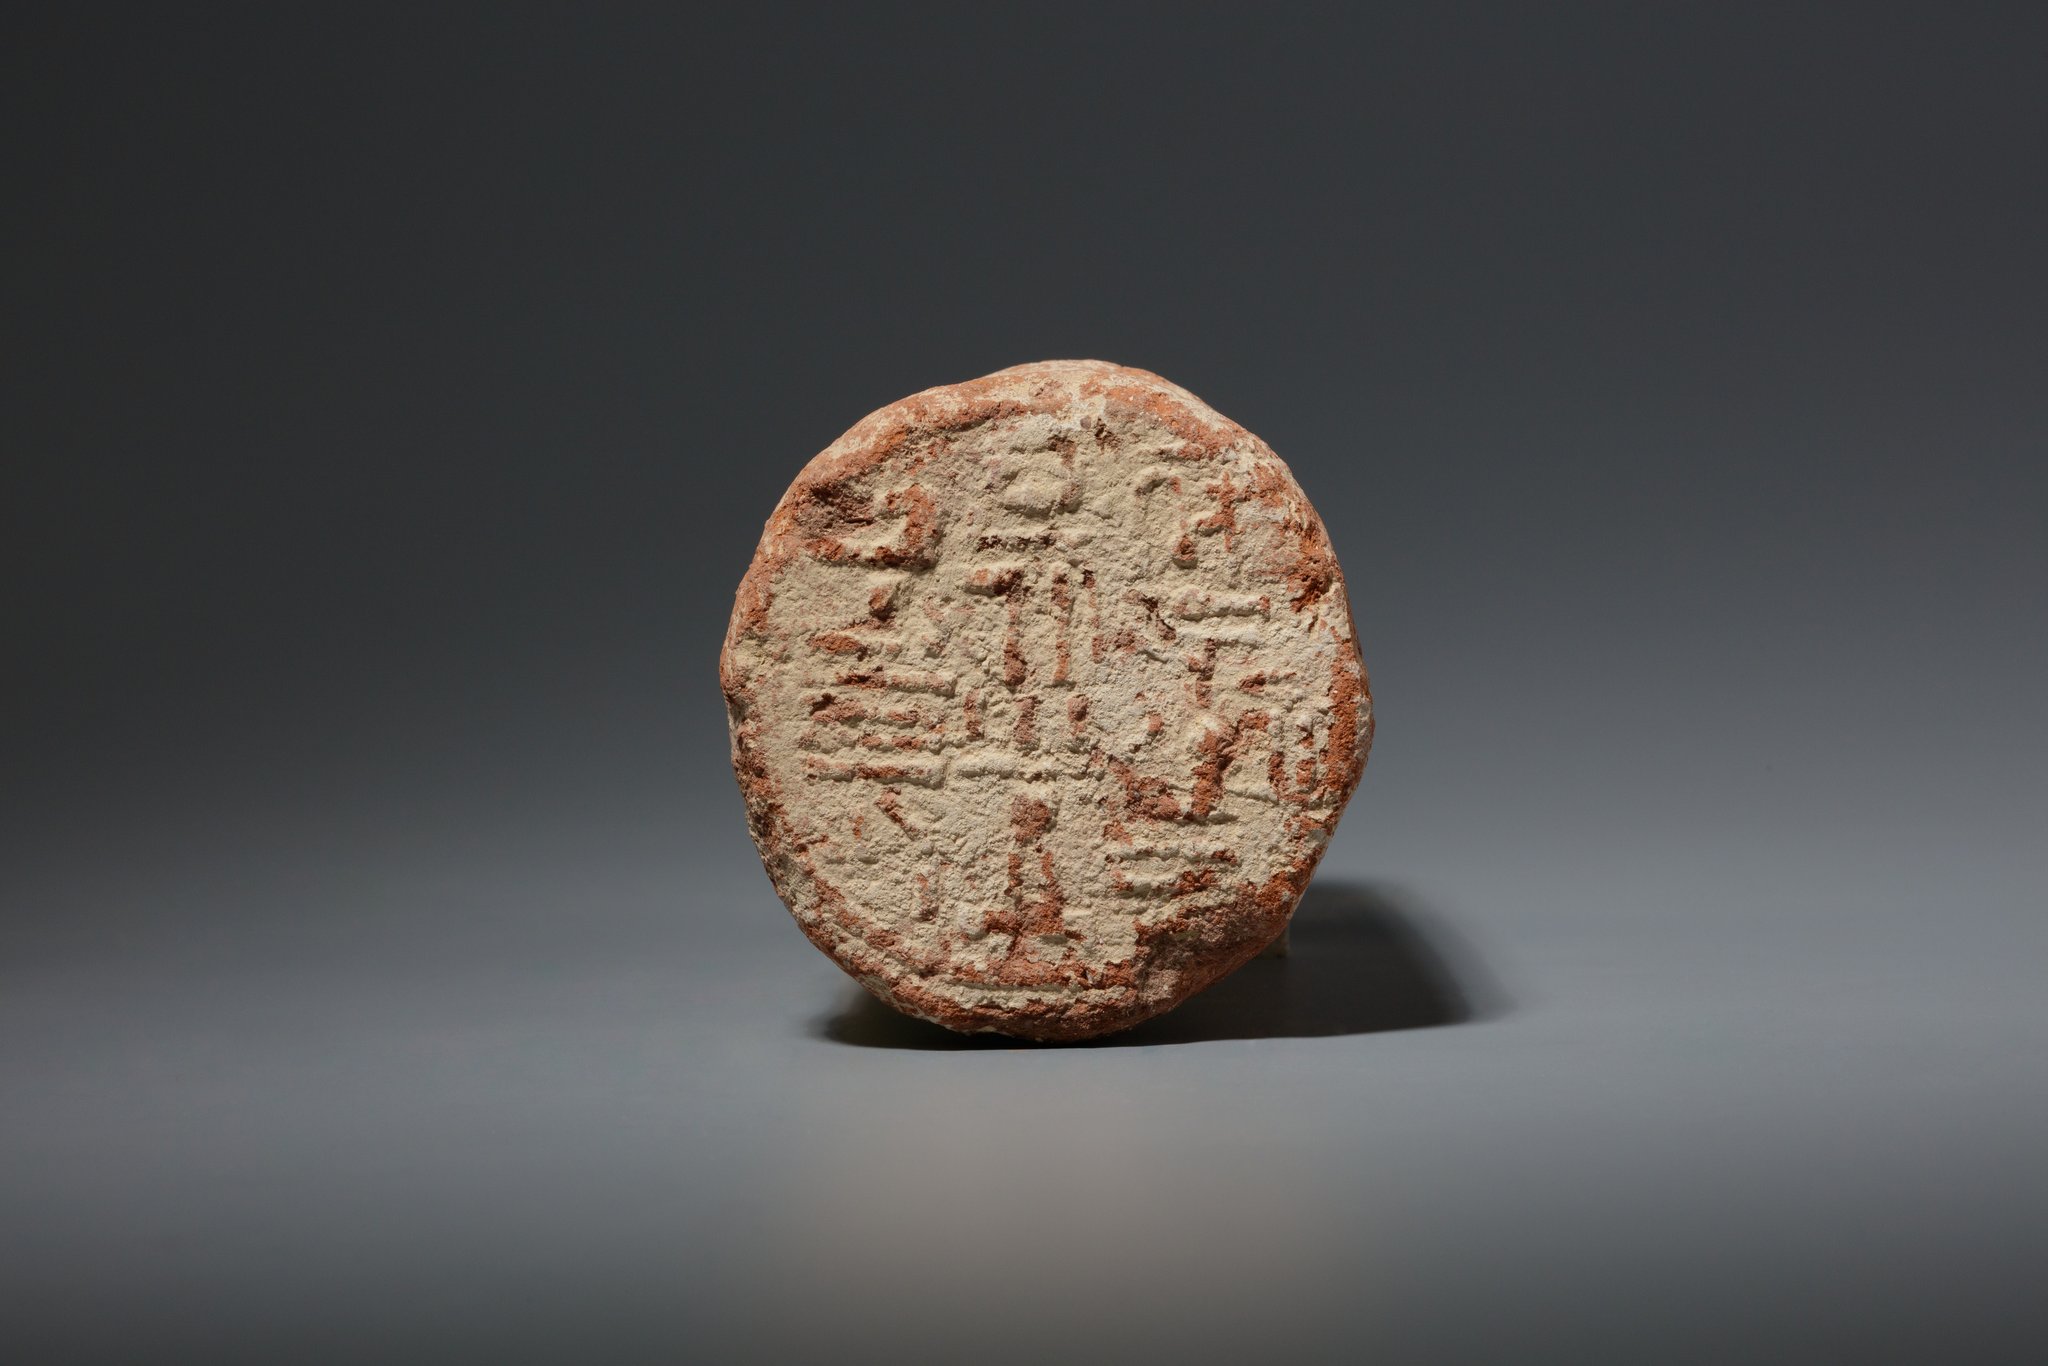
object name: cone, davy 109, min, scribe, overseer, onuris, mayor, thinis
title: Funerary Cone of the Scribe Min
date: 1479-1425 BCE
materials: pottery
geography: egypt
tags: hieroglyphs